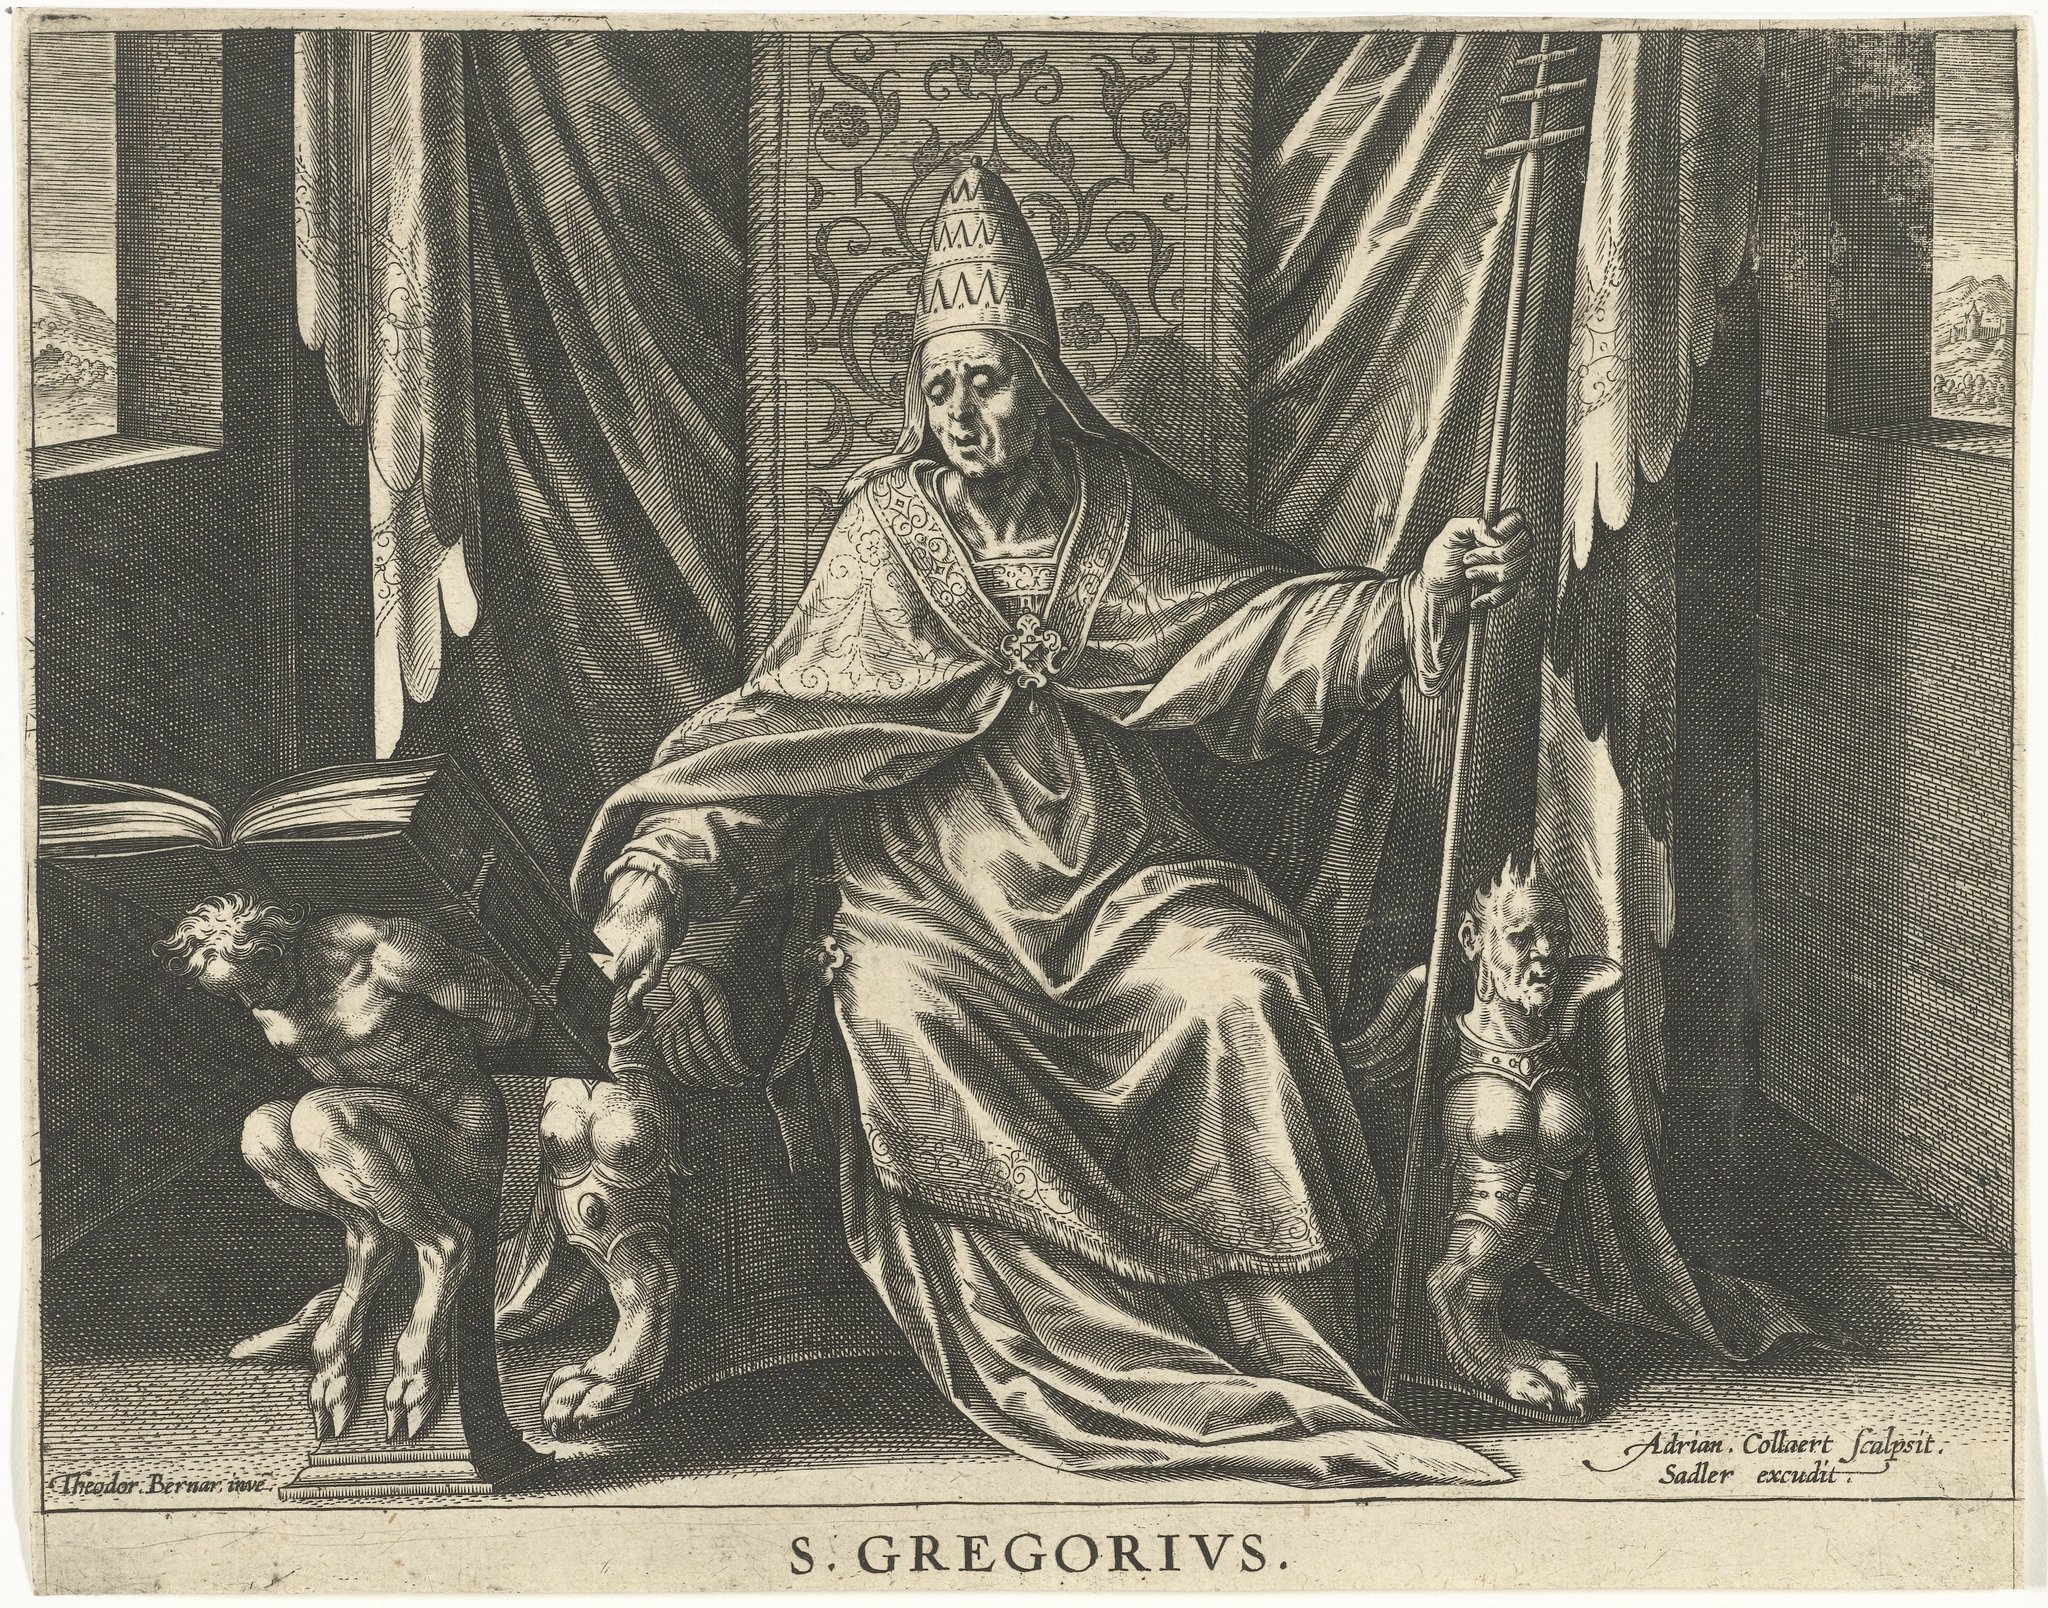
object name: print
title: Heilige Gregorius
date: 1570-1618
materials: paper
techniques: engraving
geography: antwerp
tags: pope gregory the great; possible attributes: dove, emperor trajan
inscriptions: collector's mark: Lugt 2228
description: De Heilige Gregorius, gezeten op een troon. Hij draagt de pauselijke gewaden en houdt de pauselijke staf vast. Hij leest uit een boek. De prent is deel van een vierdelige serie over de vier kerkvaders.